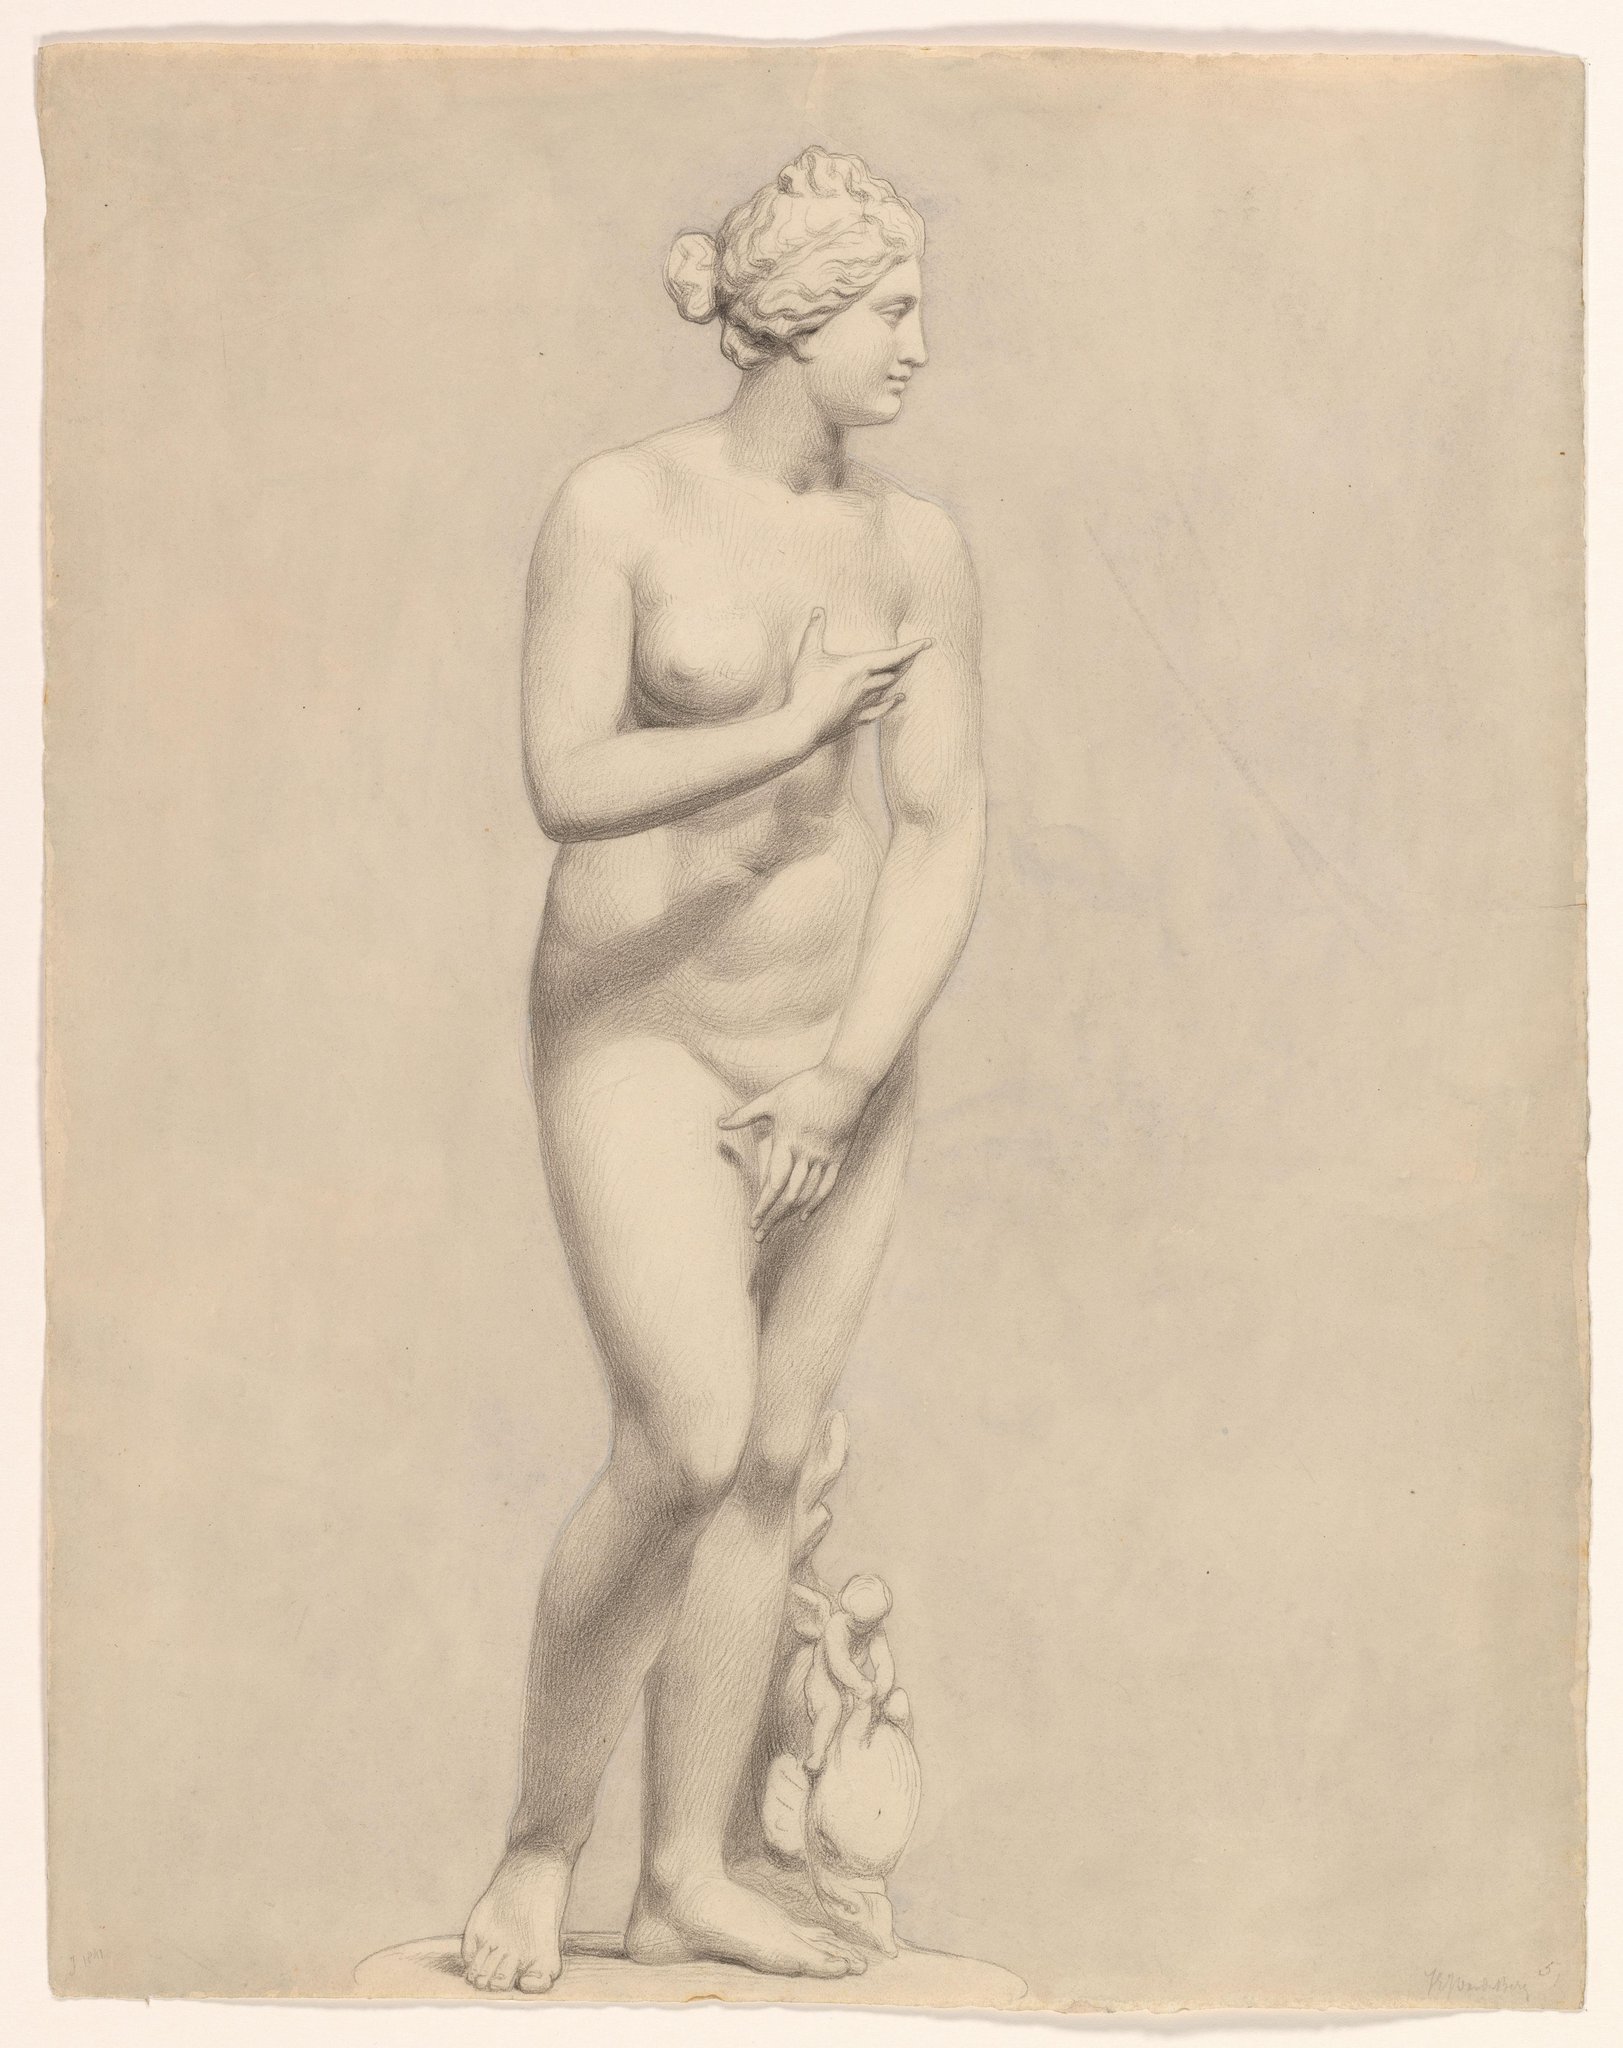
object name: drawing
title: Venus de' Medici, van voren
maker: jacobus everhardus josephus van den berg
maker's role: draughtsman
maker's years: 1802-1861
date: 1812-1861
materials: chalk, paper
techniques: brush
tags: piece of sculpture, reproduction of a piece of sculpture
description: Academiestudie naar pleistermodel van antiek beeld.